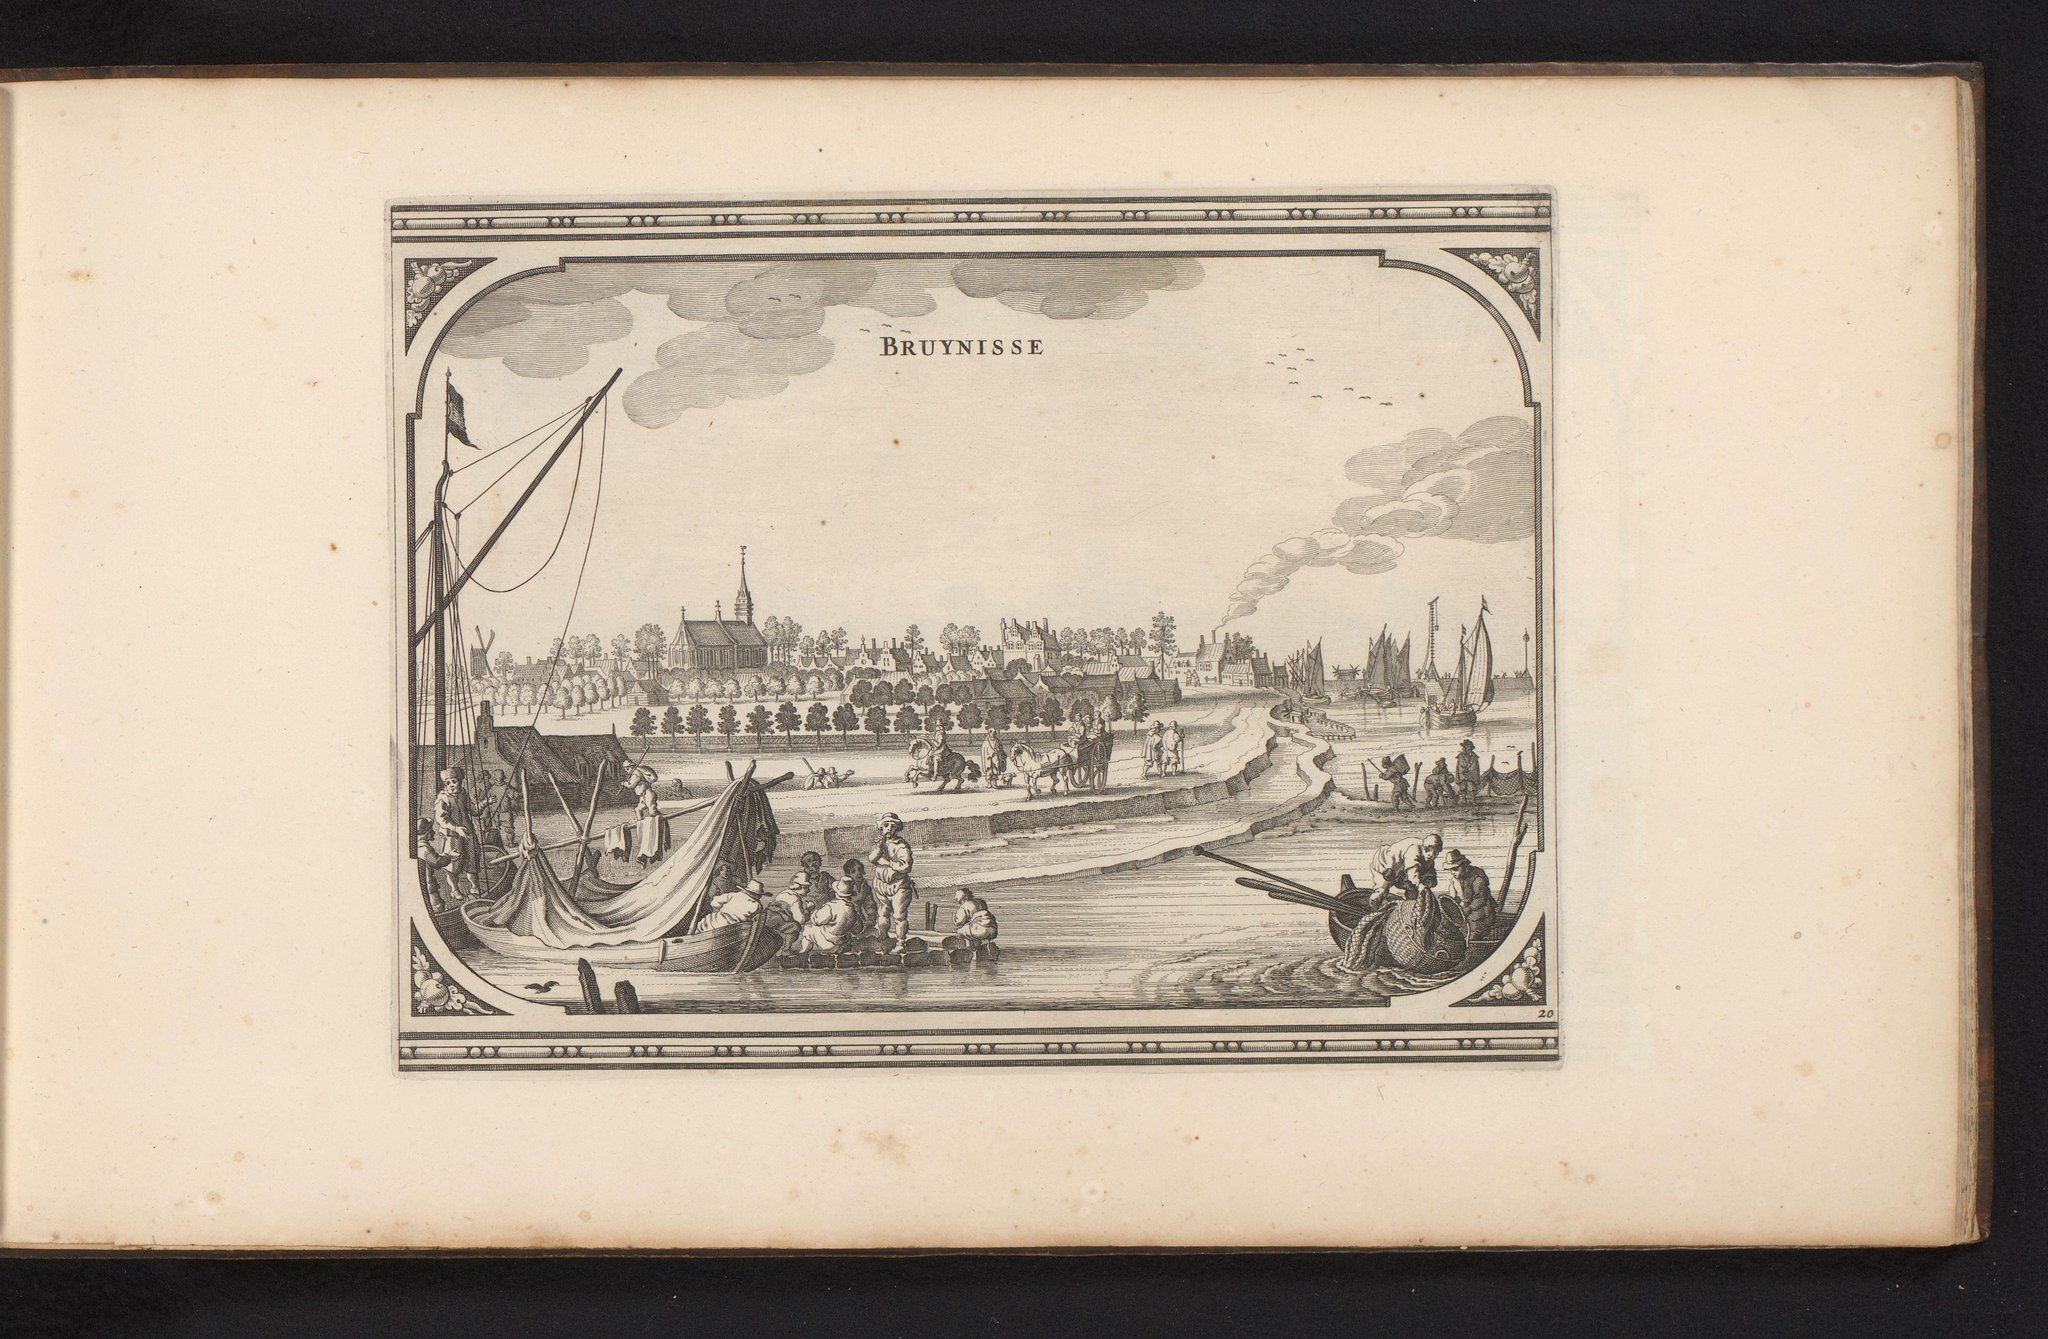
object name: album leaf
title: Bruynisse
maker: pieter hendricksz. schut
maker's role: print maker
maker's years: 1618-1660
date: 1662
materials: paper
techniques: etching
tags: city-view, and landscape with man-made constructions, pipe ~ tobacco, fisherman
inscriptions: collector's mark: Lugt 195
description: Gezicht op de stad Bruinisse. Rechts op de voorgrond halen twee mannen een eendenkooi of fuik uit het water. Links bij een boot zit een groep mannen. Eén van de mannen rookt een pijp. De prent maakt deel uit van een album.